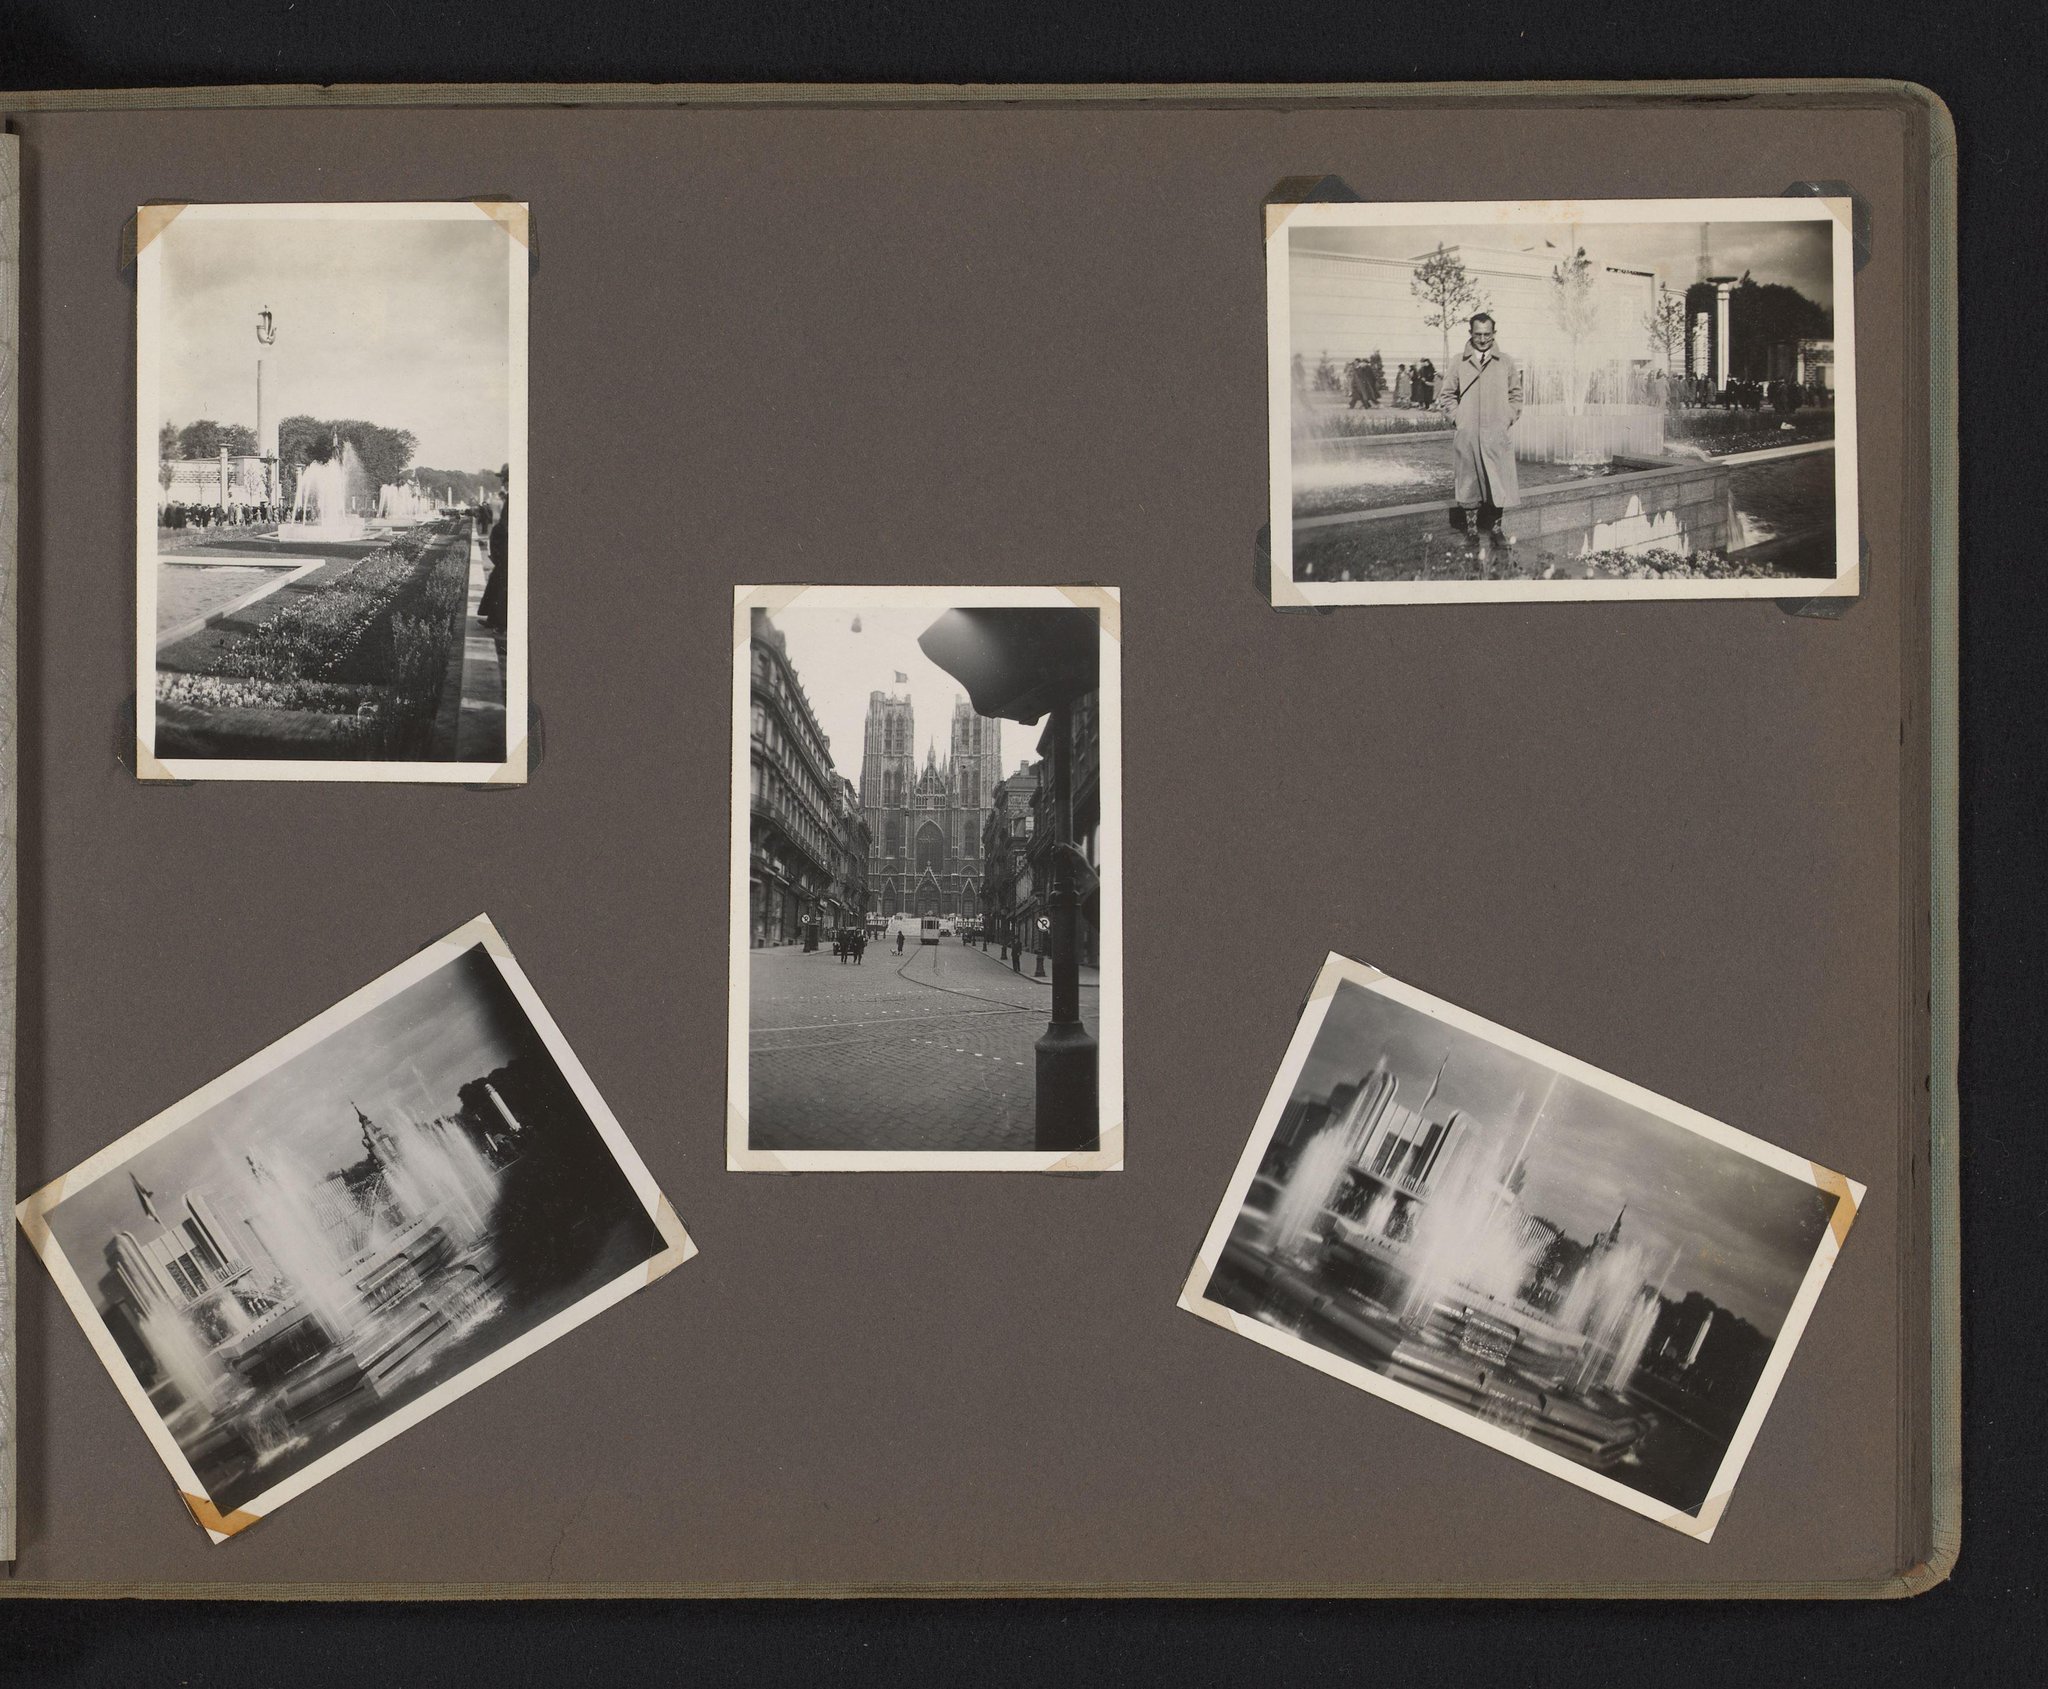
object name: album leaf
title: Fonteinen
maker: Anonymous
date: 1935-1945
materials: cardboard, photographic support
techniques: gelatin silver print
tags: church (exterior), outing, pleasure trip, ornamental fountain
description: Albumblad met vijf foto's van een bezoek aan een stad met fonteinen en een kathedraal, met de vriend. Onderdeel van het fotoalbum van een jonge vrouw, ca. 1935-1945.